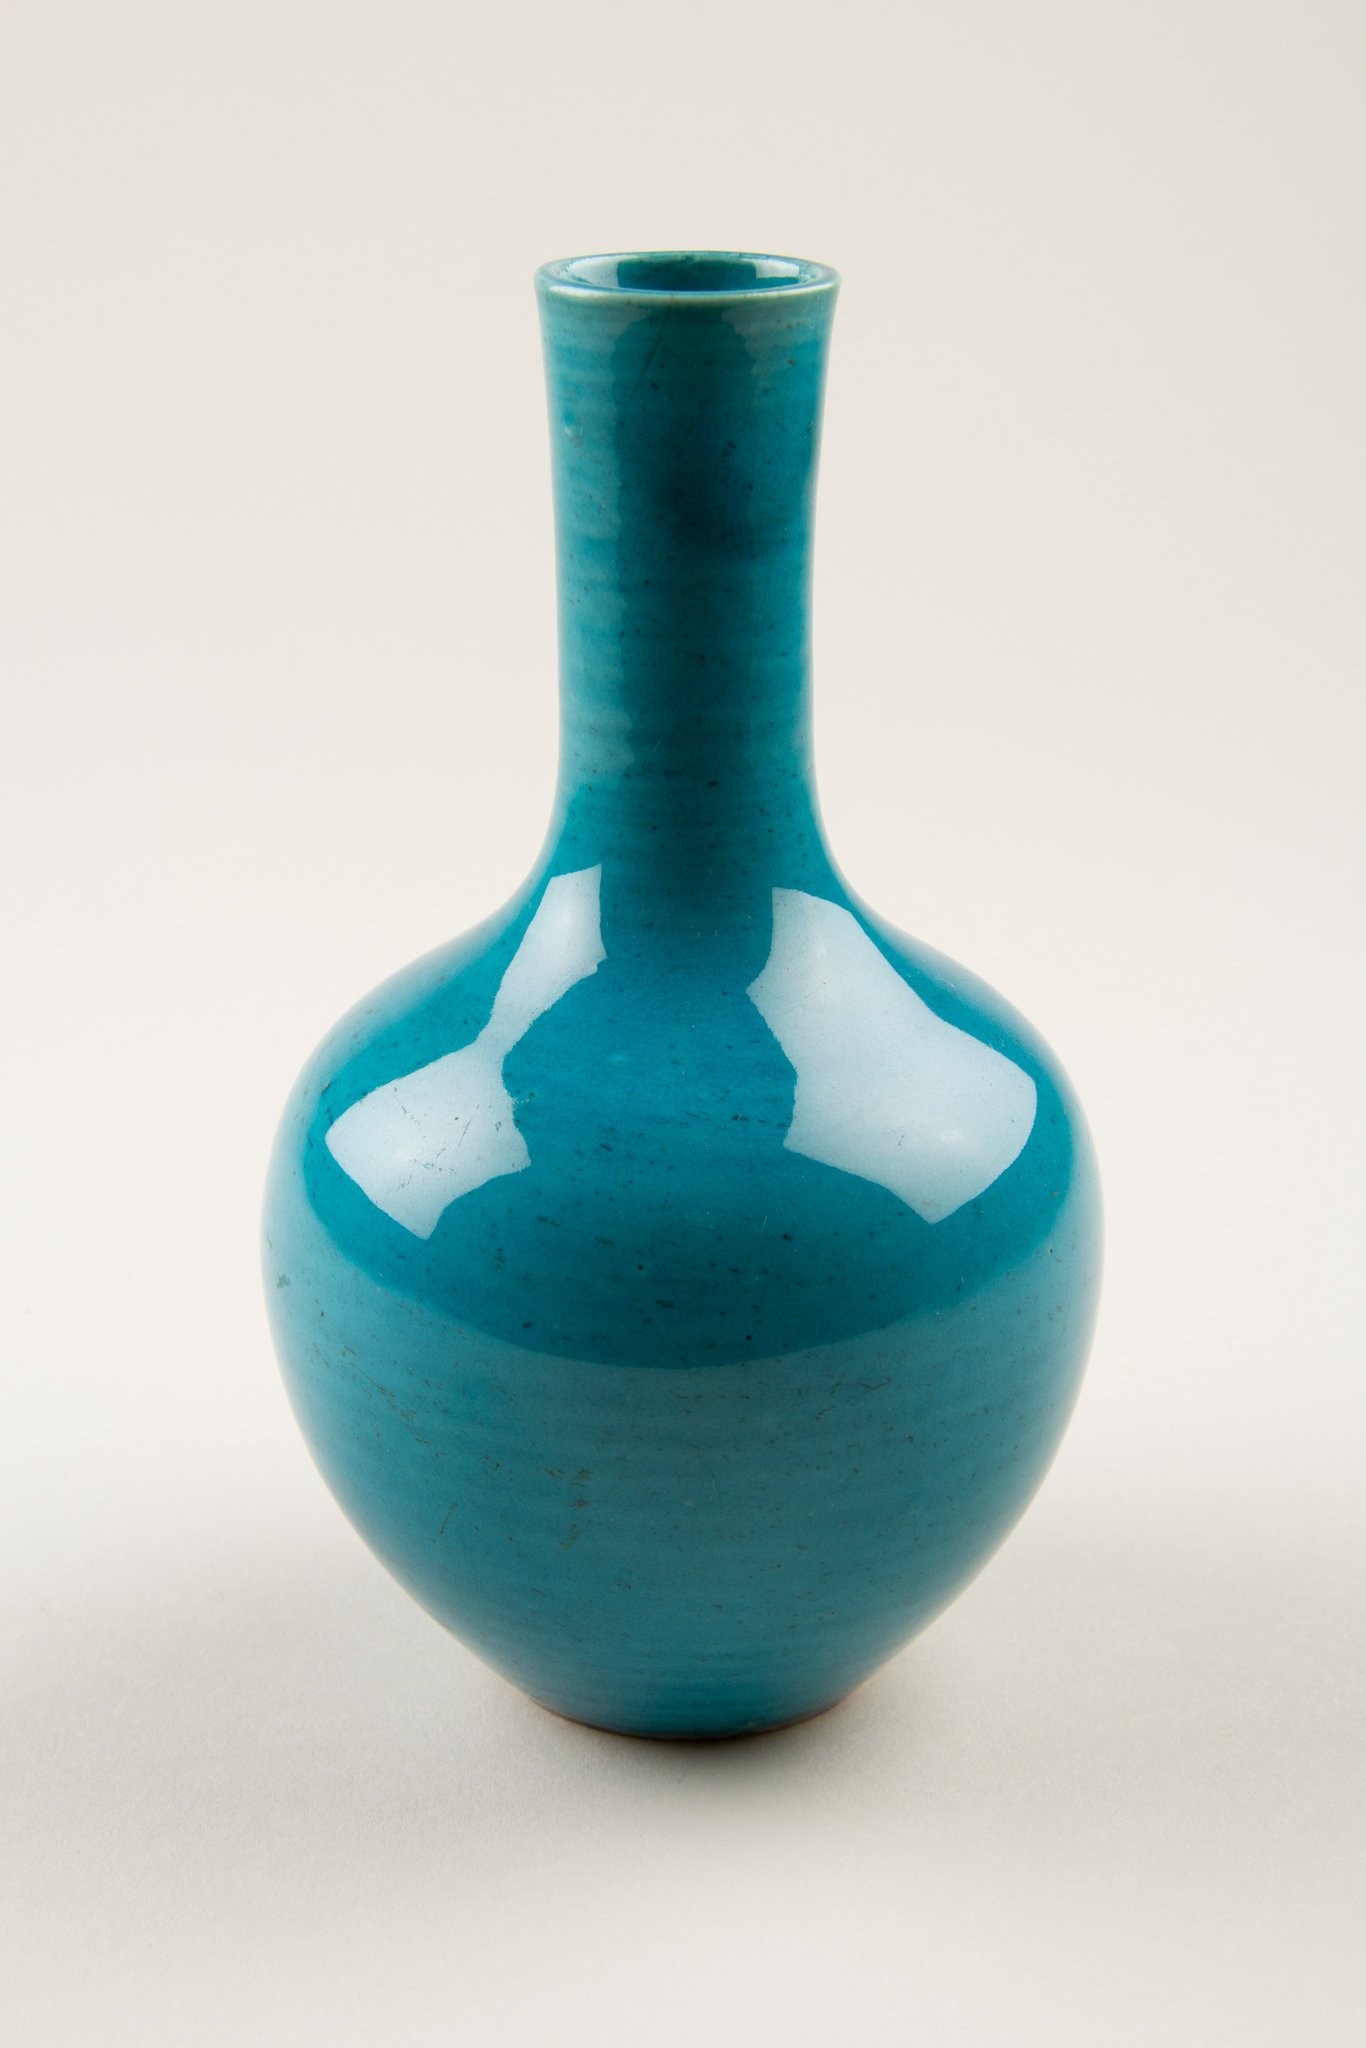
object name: vase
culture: chinese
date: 1723-1735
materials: porcelain